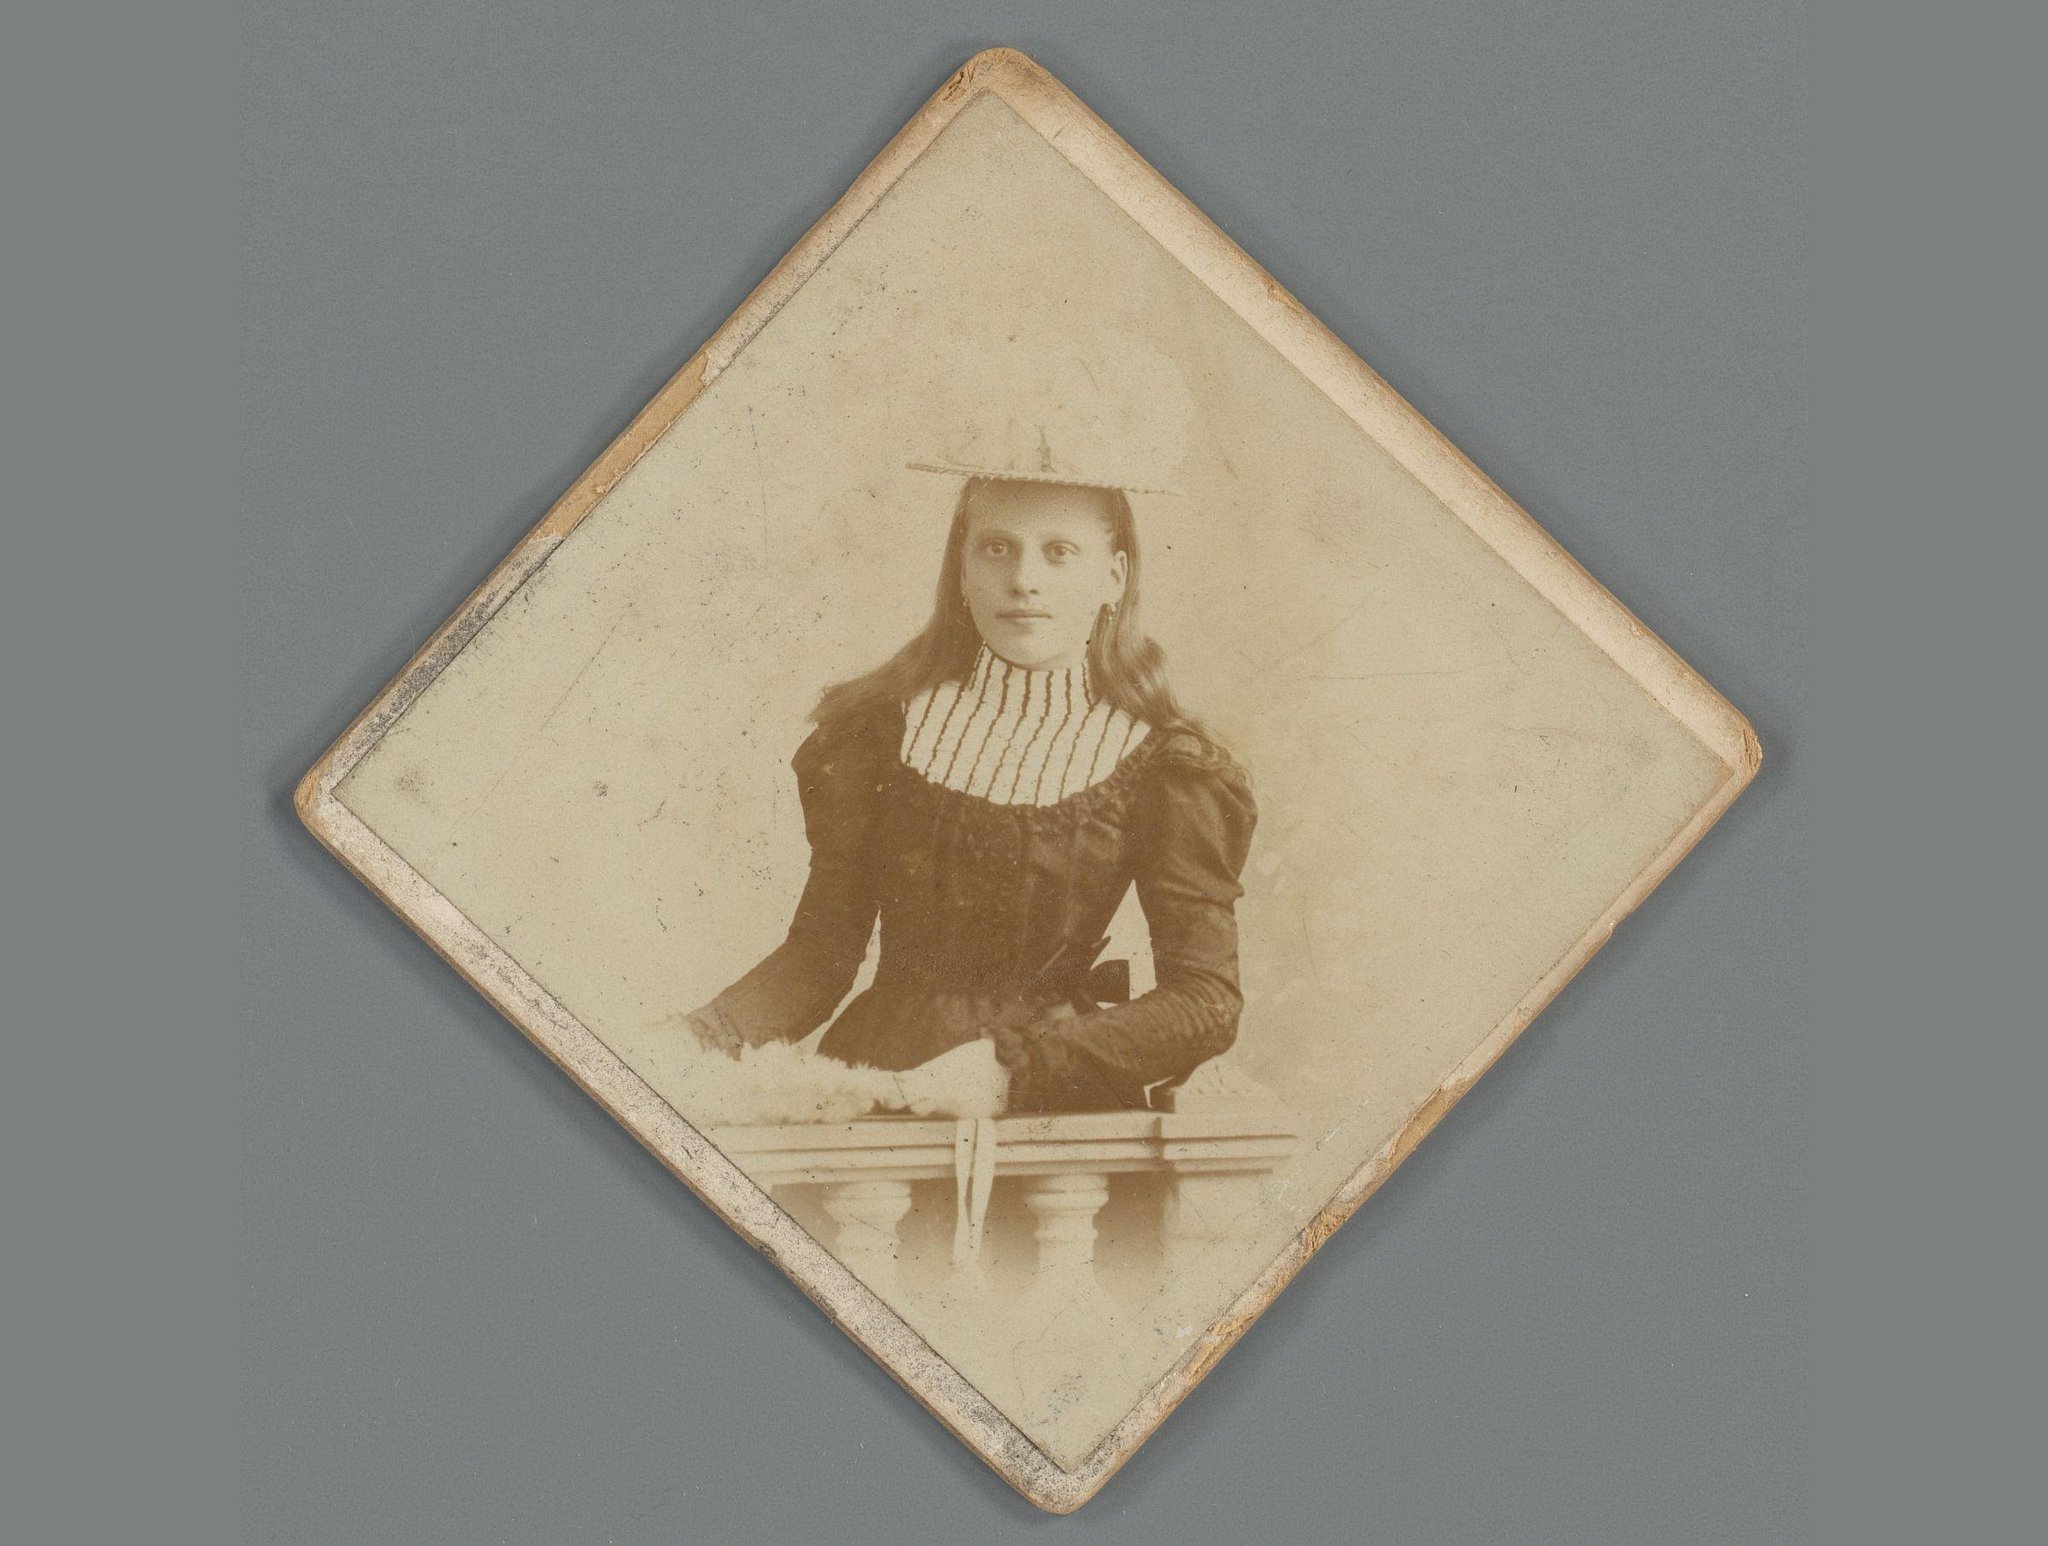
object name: photograph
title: Portret van een onbekende jonge vrouw met hoed, 45 graden gedraaid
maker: Anonymous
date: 1880-1910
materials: paper, cardboard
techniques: collodion silver print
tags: adolescent, young woman, maiden, anonymous historical person portrayed